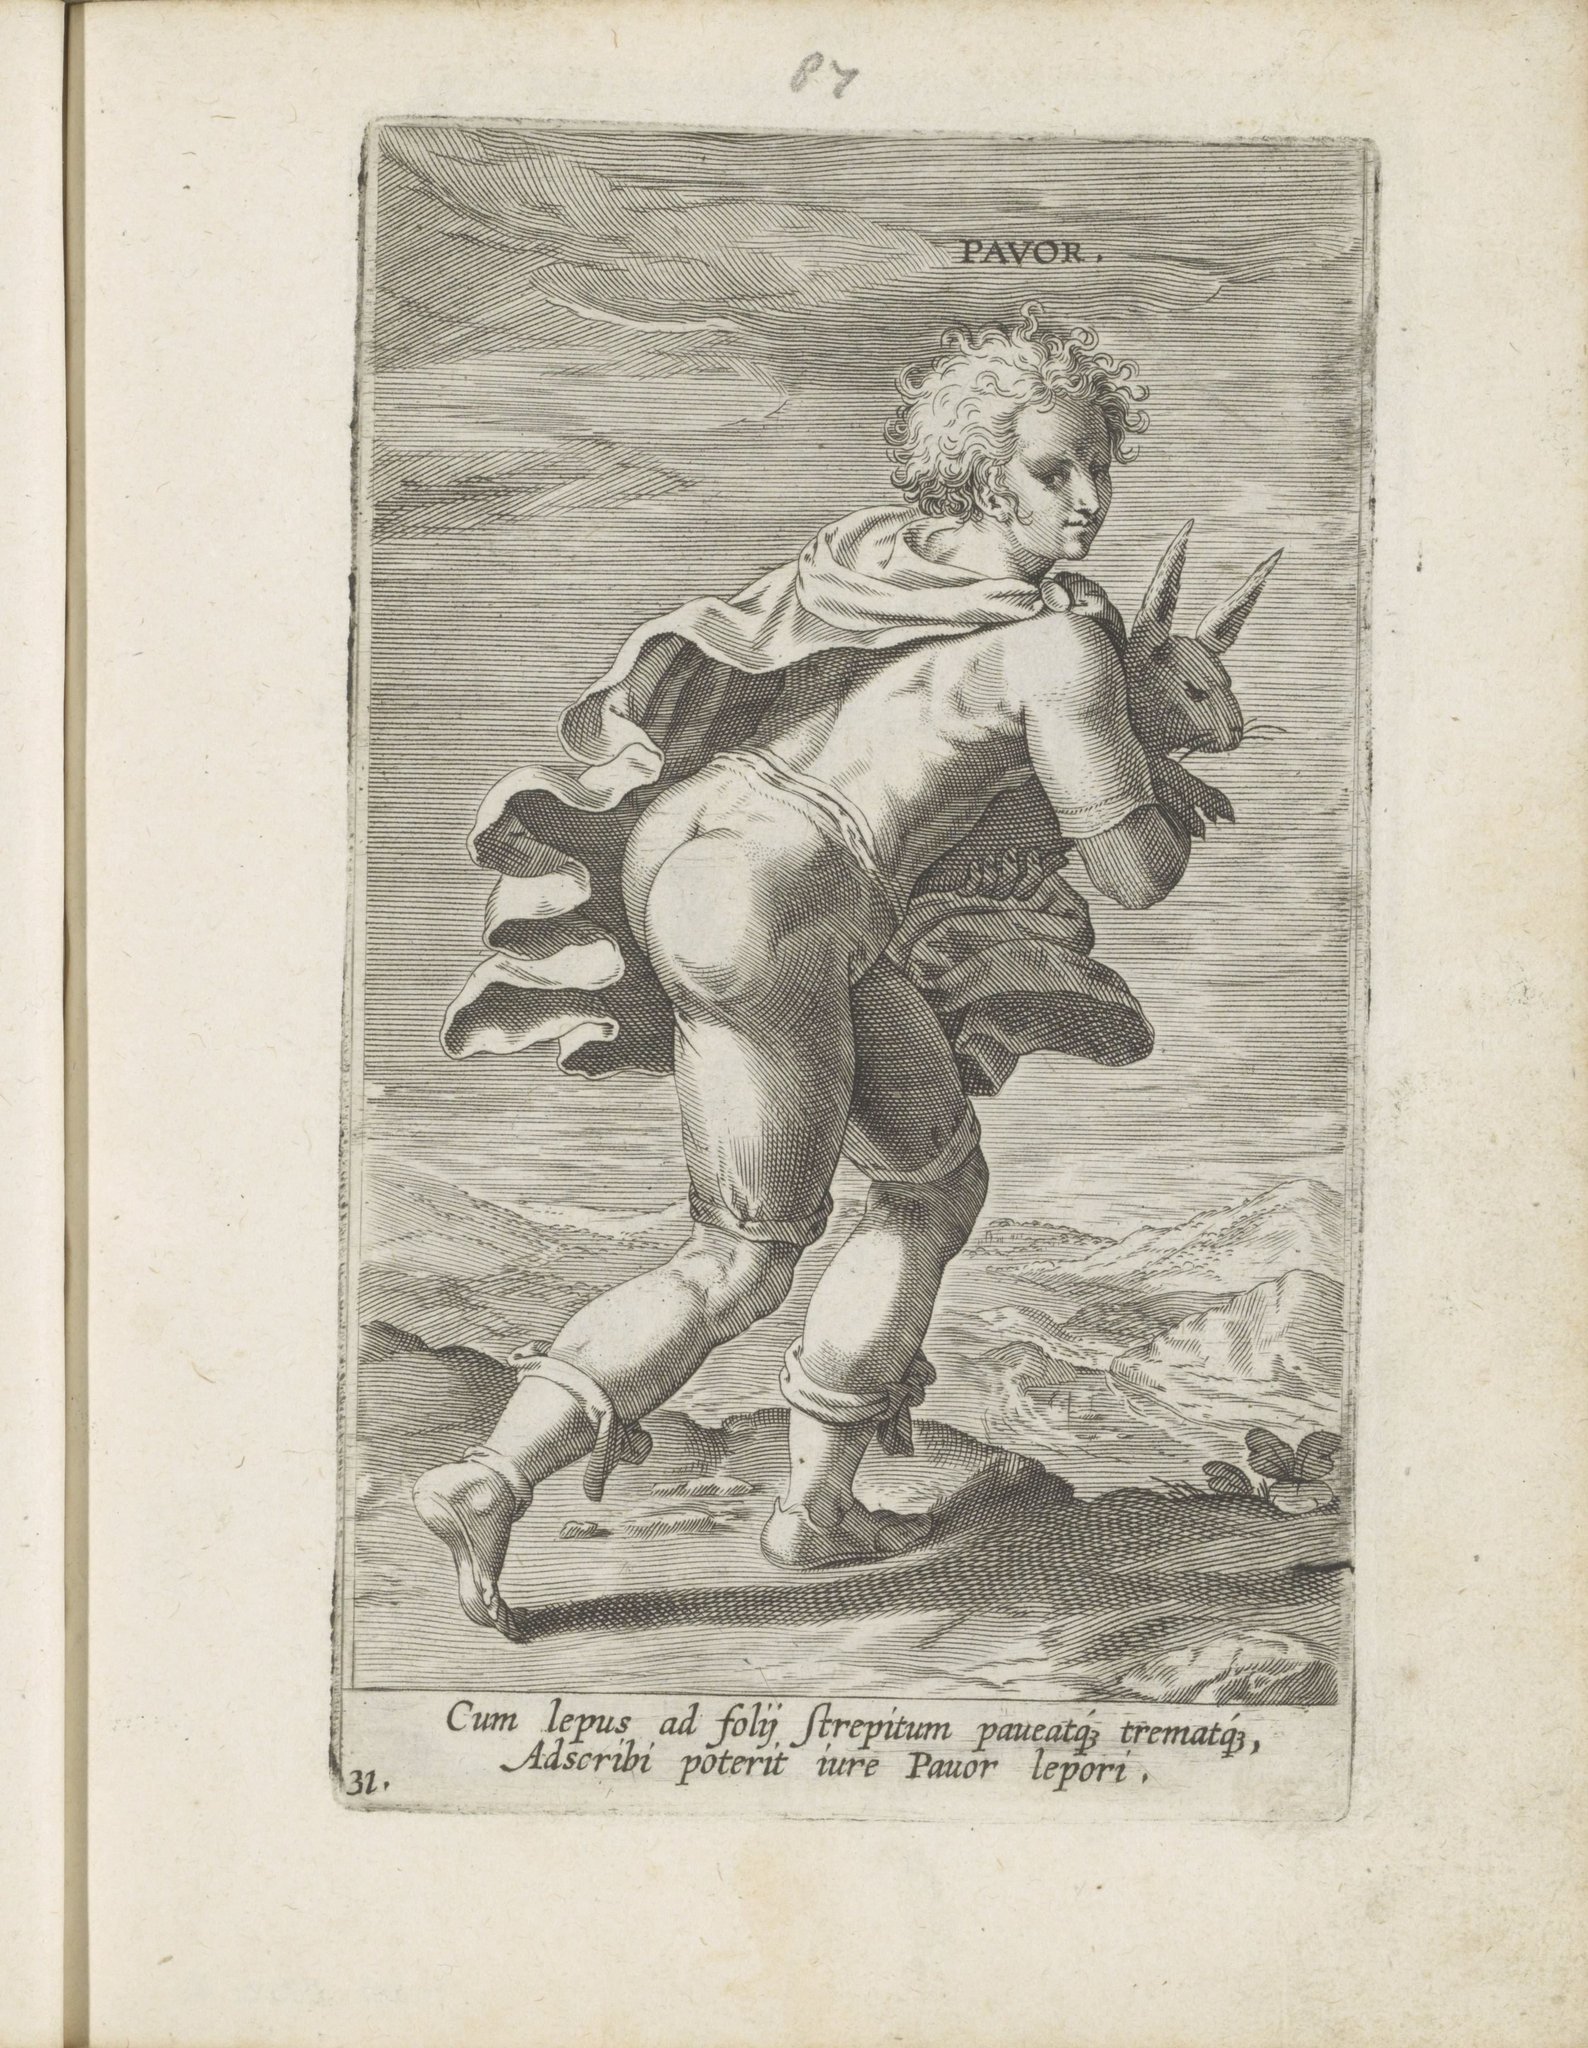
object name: album leaf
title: Vrees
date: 1585-1590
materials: paper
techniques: engraving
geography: southern netherlands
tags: rodents: hare, fear, dread; 'paura', 'timidità o timore', 'timore' (ripa)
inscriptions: collector's mark: Lugt 2760, collector's mark: Lugt 2228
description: Een jongen rent weg met een haas in zijn armen terwijl hij achterom kijkt. De haas is een vreesachtig dier dat wegrent bij de minste beweging. Onder de voorstelling twee regels tekst in het Latijn. De prent maakt deel uit van een album.